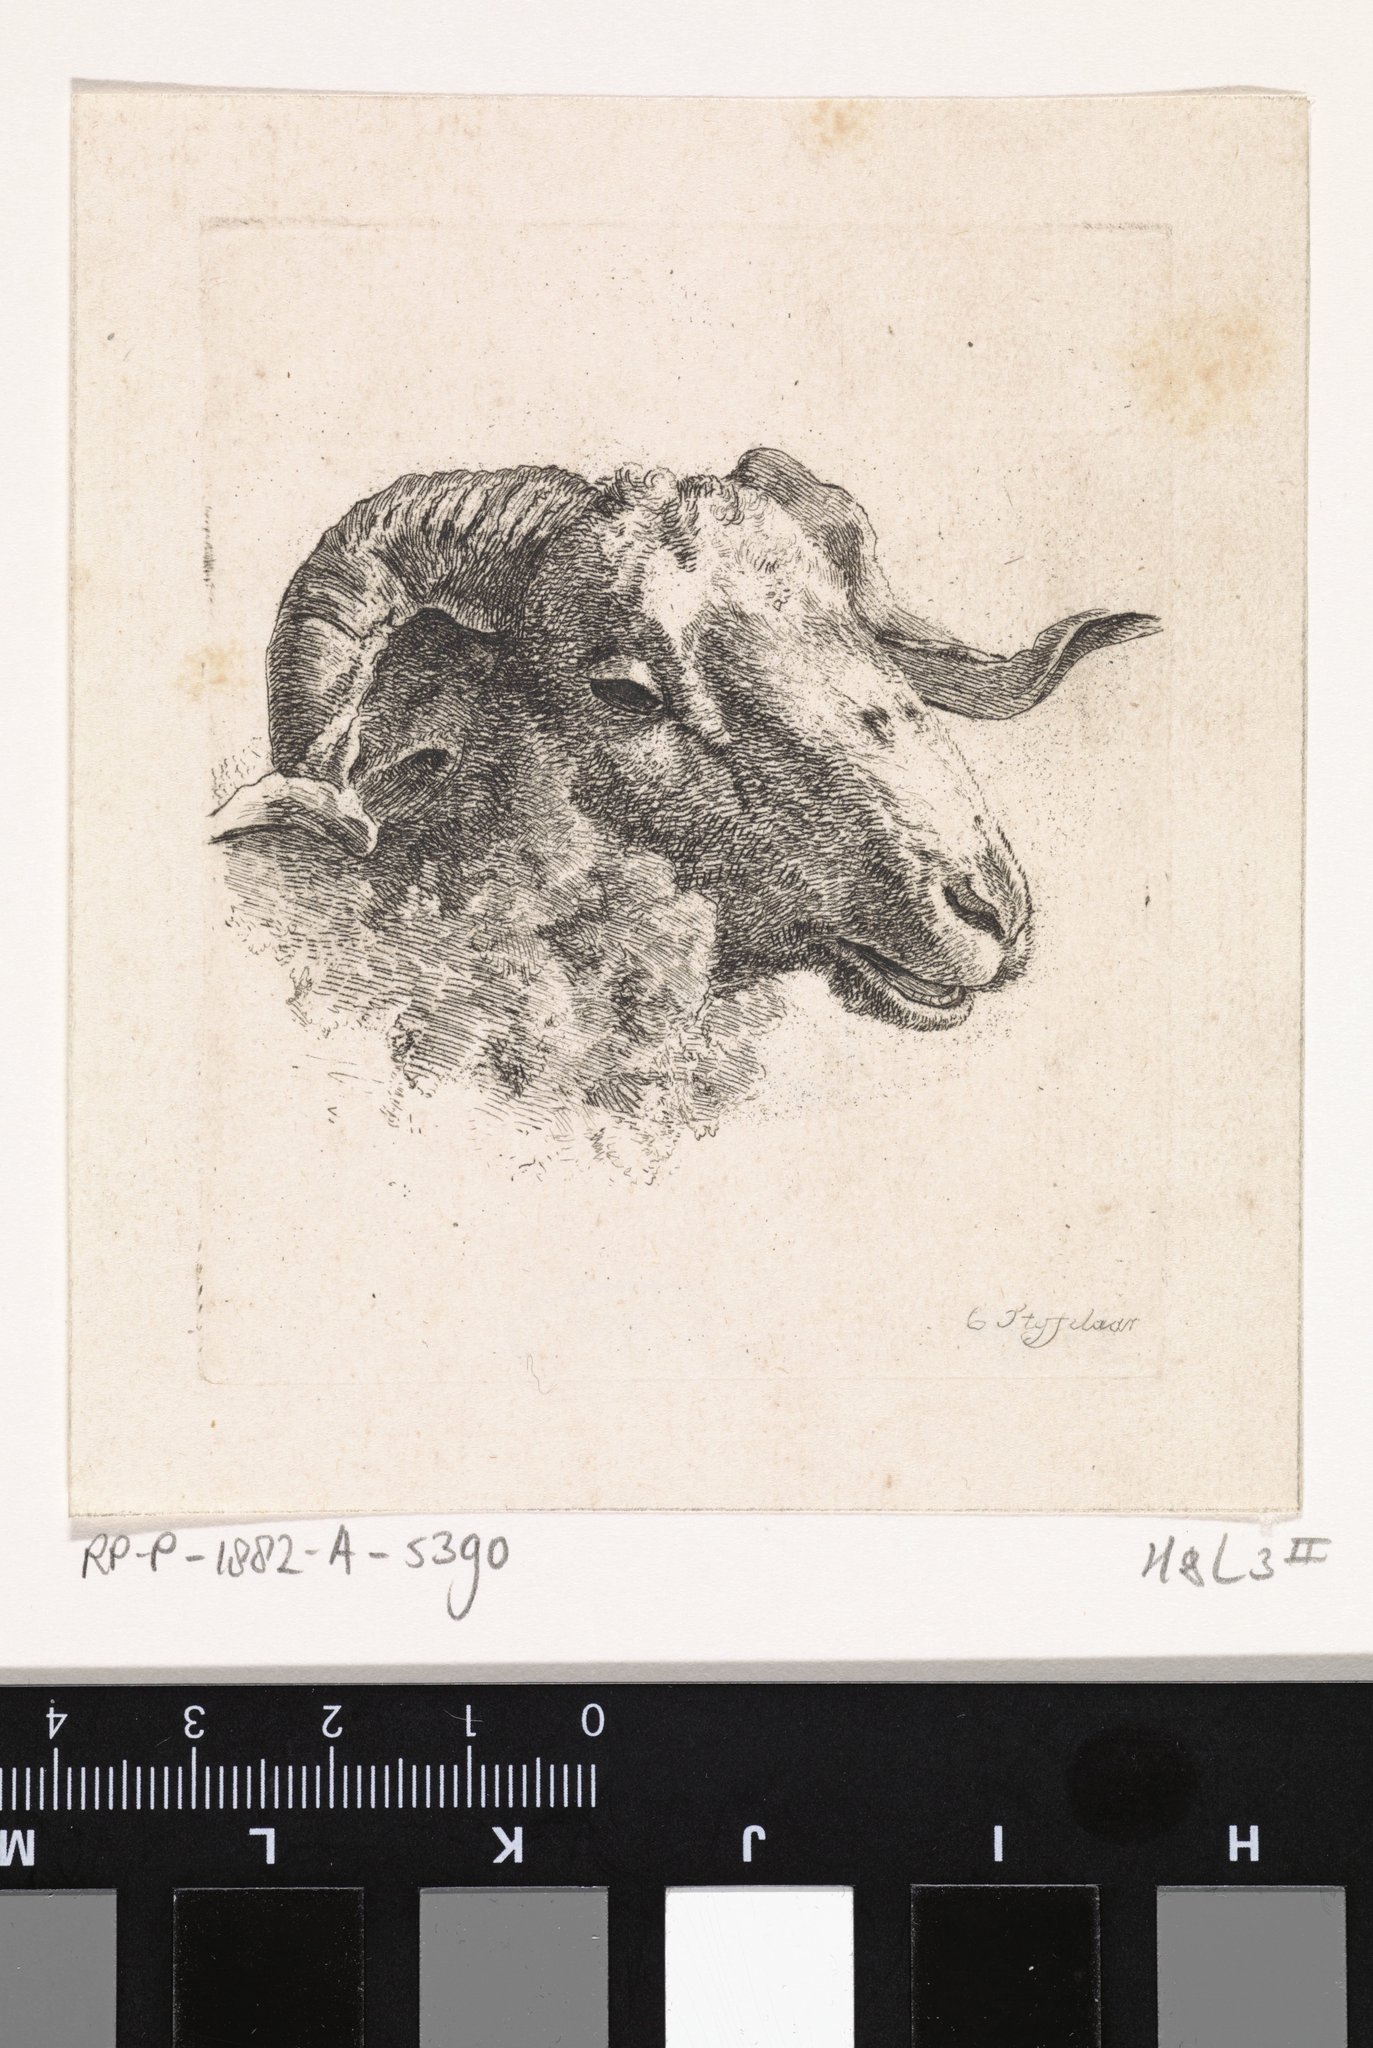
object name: print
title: Kop van een ram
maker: cornelis steffelaar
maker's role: draughtsman, painter, print maker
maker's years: 1797-1861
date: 1807-1861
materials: paper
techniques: aquatint, etching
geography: amsterdam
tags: ram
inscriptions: collector's mark: Lugt 2228